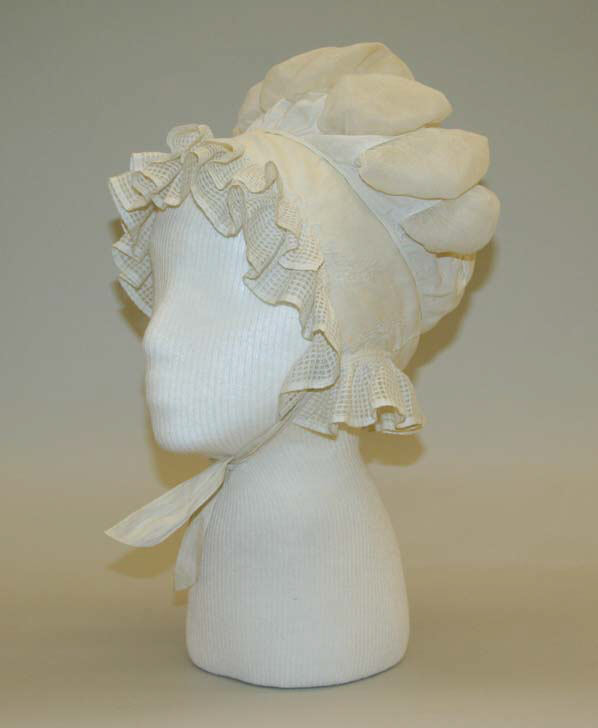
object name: cap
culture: american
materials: cotton